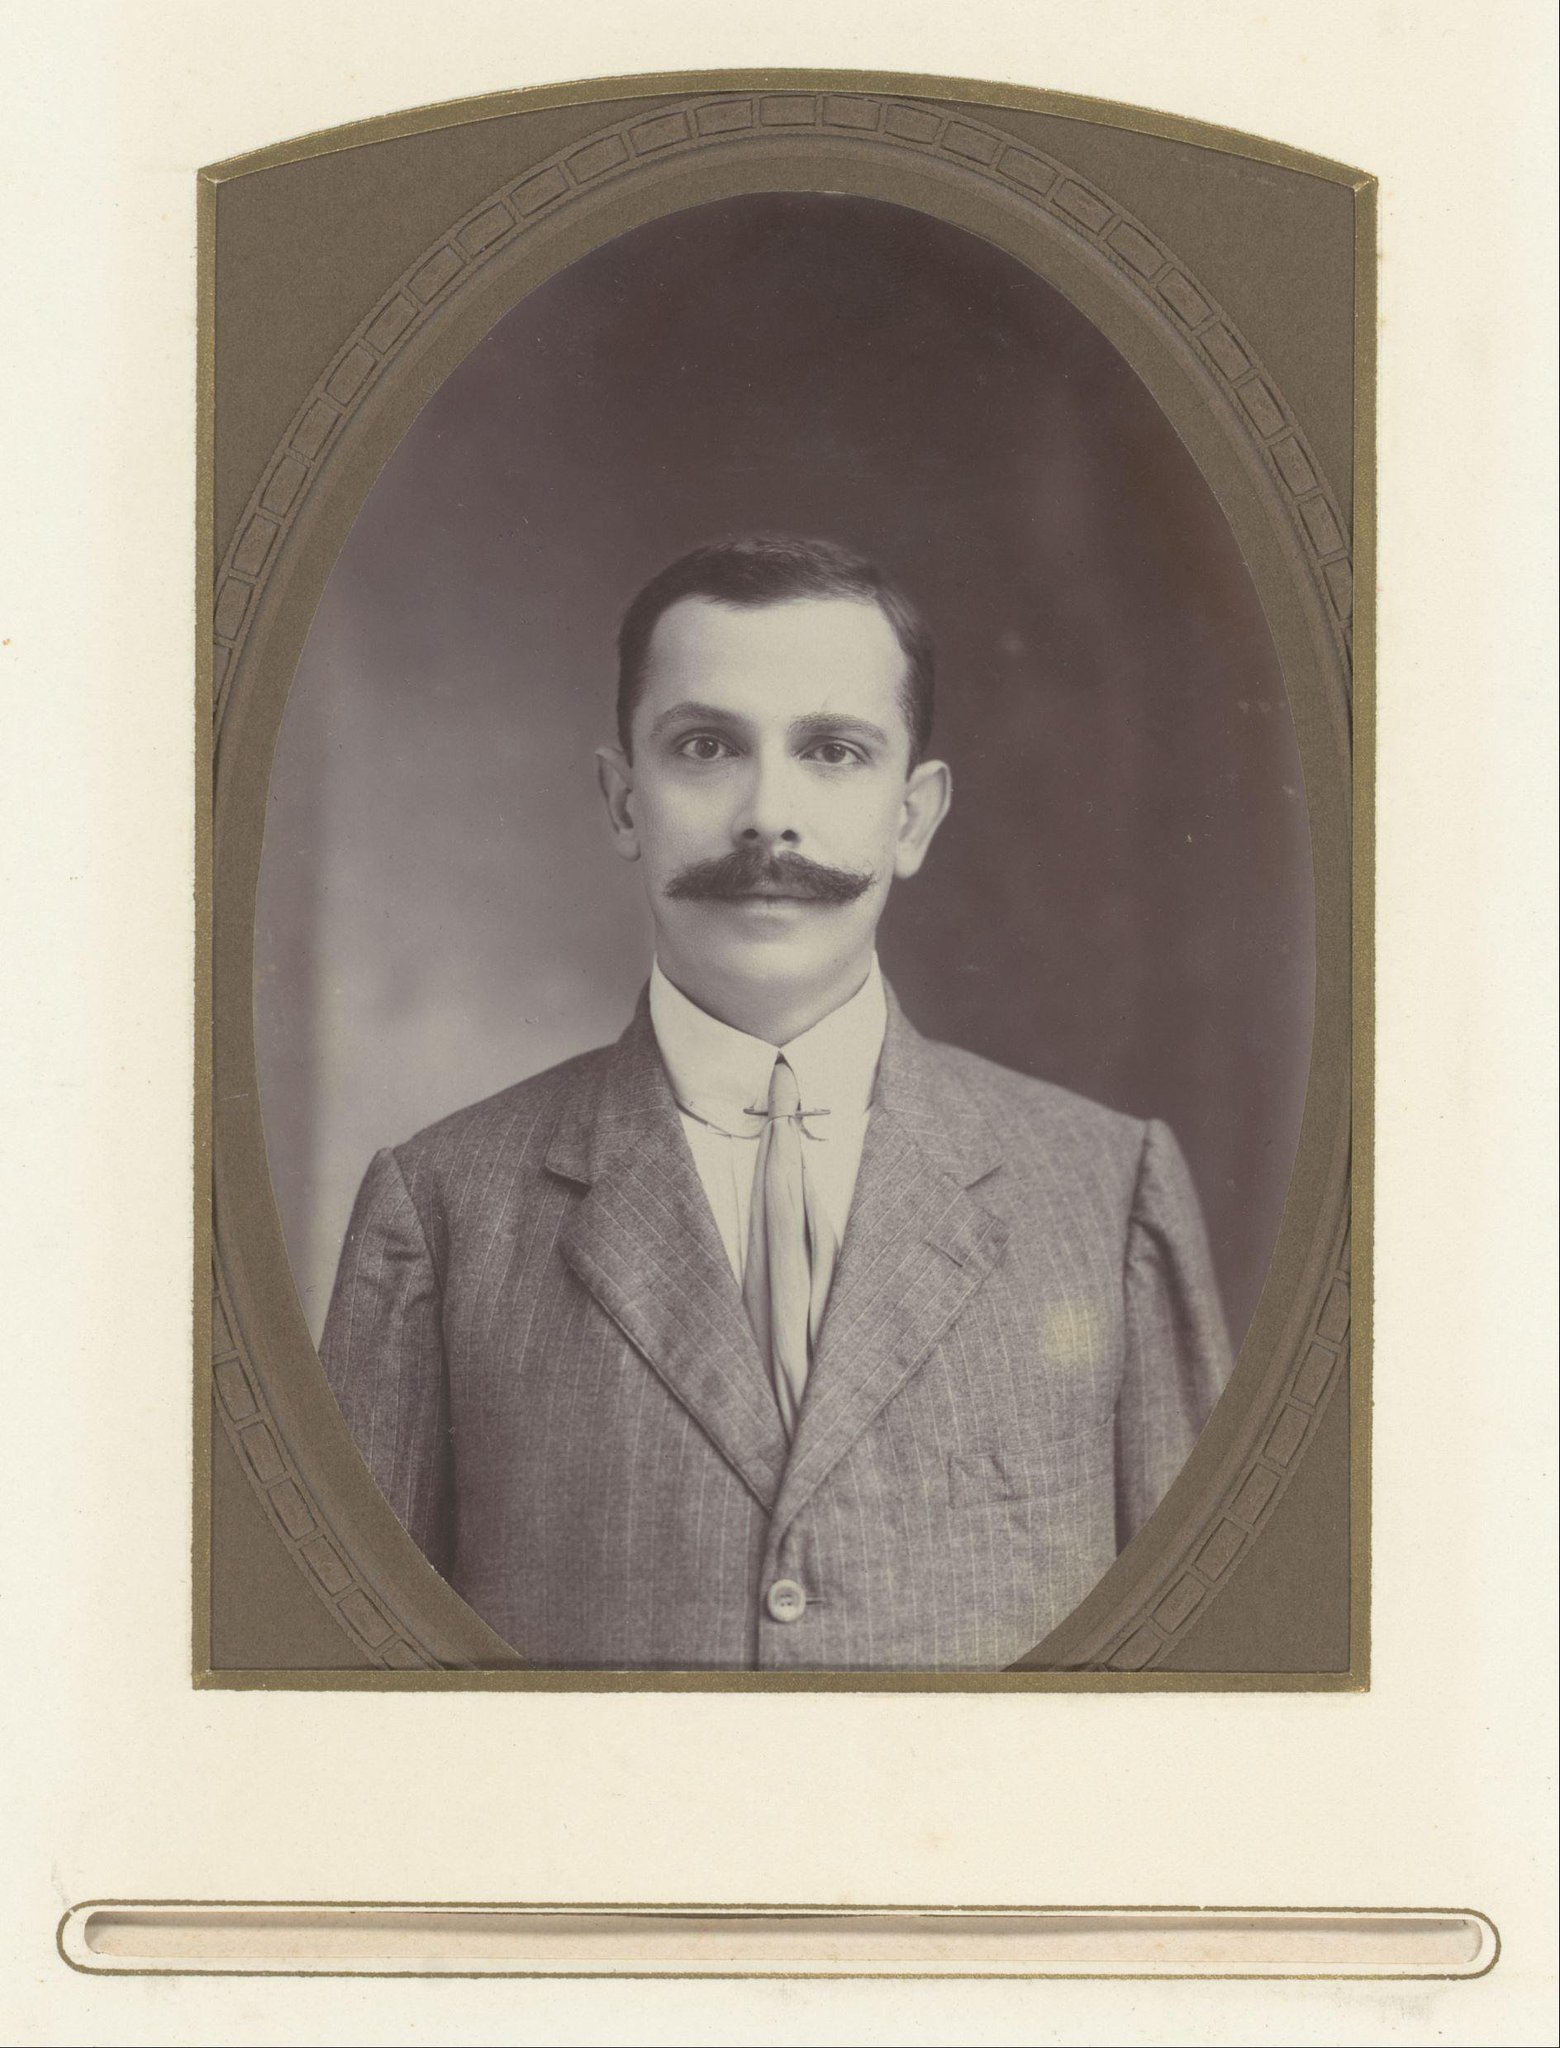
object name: cabinet photograph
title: Portret van een man met snor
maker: Anonymous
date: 1882-1940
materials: cardboard, photographic support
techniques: gelatin silver print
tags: moustache, historical persons